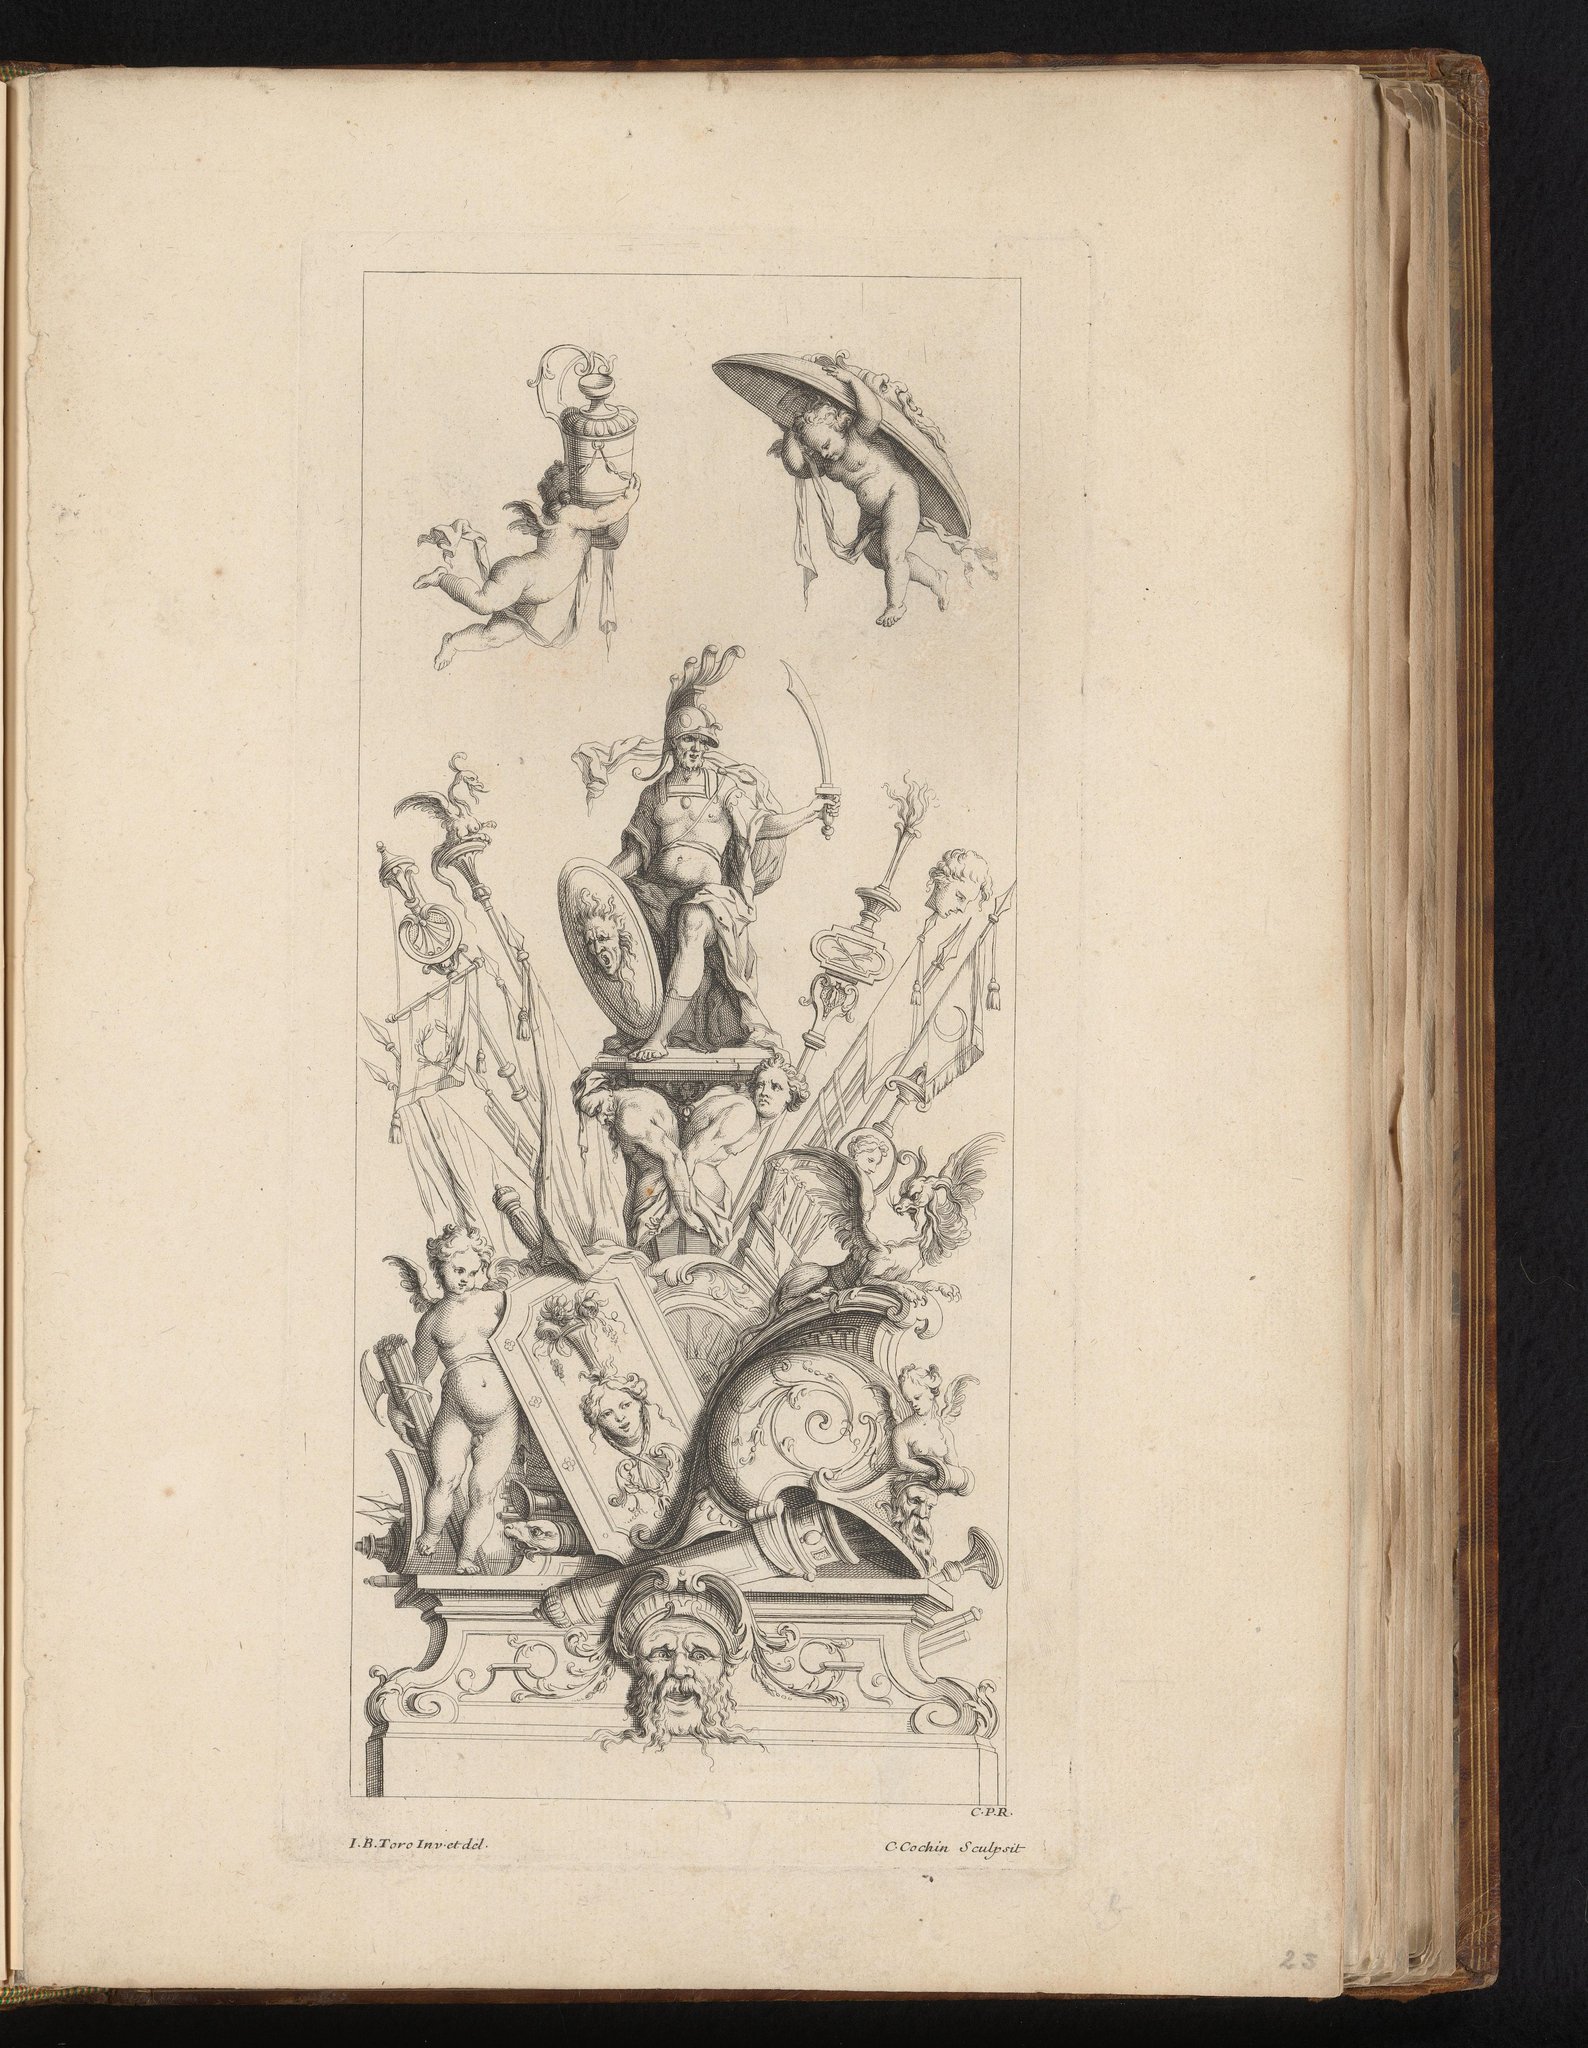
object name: print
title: Oorlogstrofee met tronende Mars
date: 1716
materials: paper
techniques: etching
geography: france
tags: (story of) mars (ares), 'tropaion', i.e. decorative ornament ~ weapons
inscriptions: collector's mark: Lugt 2760, collector's mark: Lugt 2228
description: Prent maakt deel uit van een serie van zes prenten.